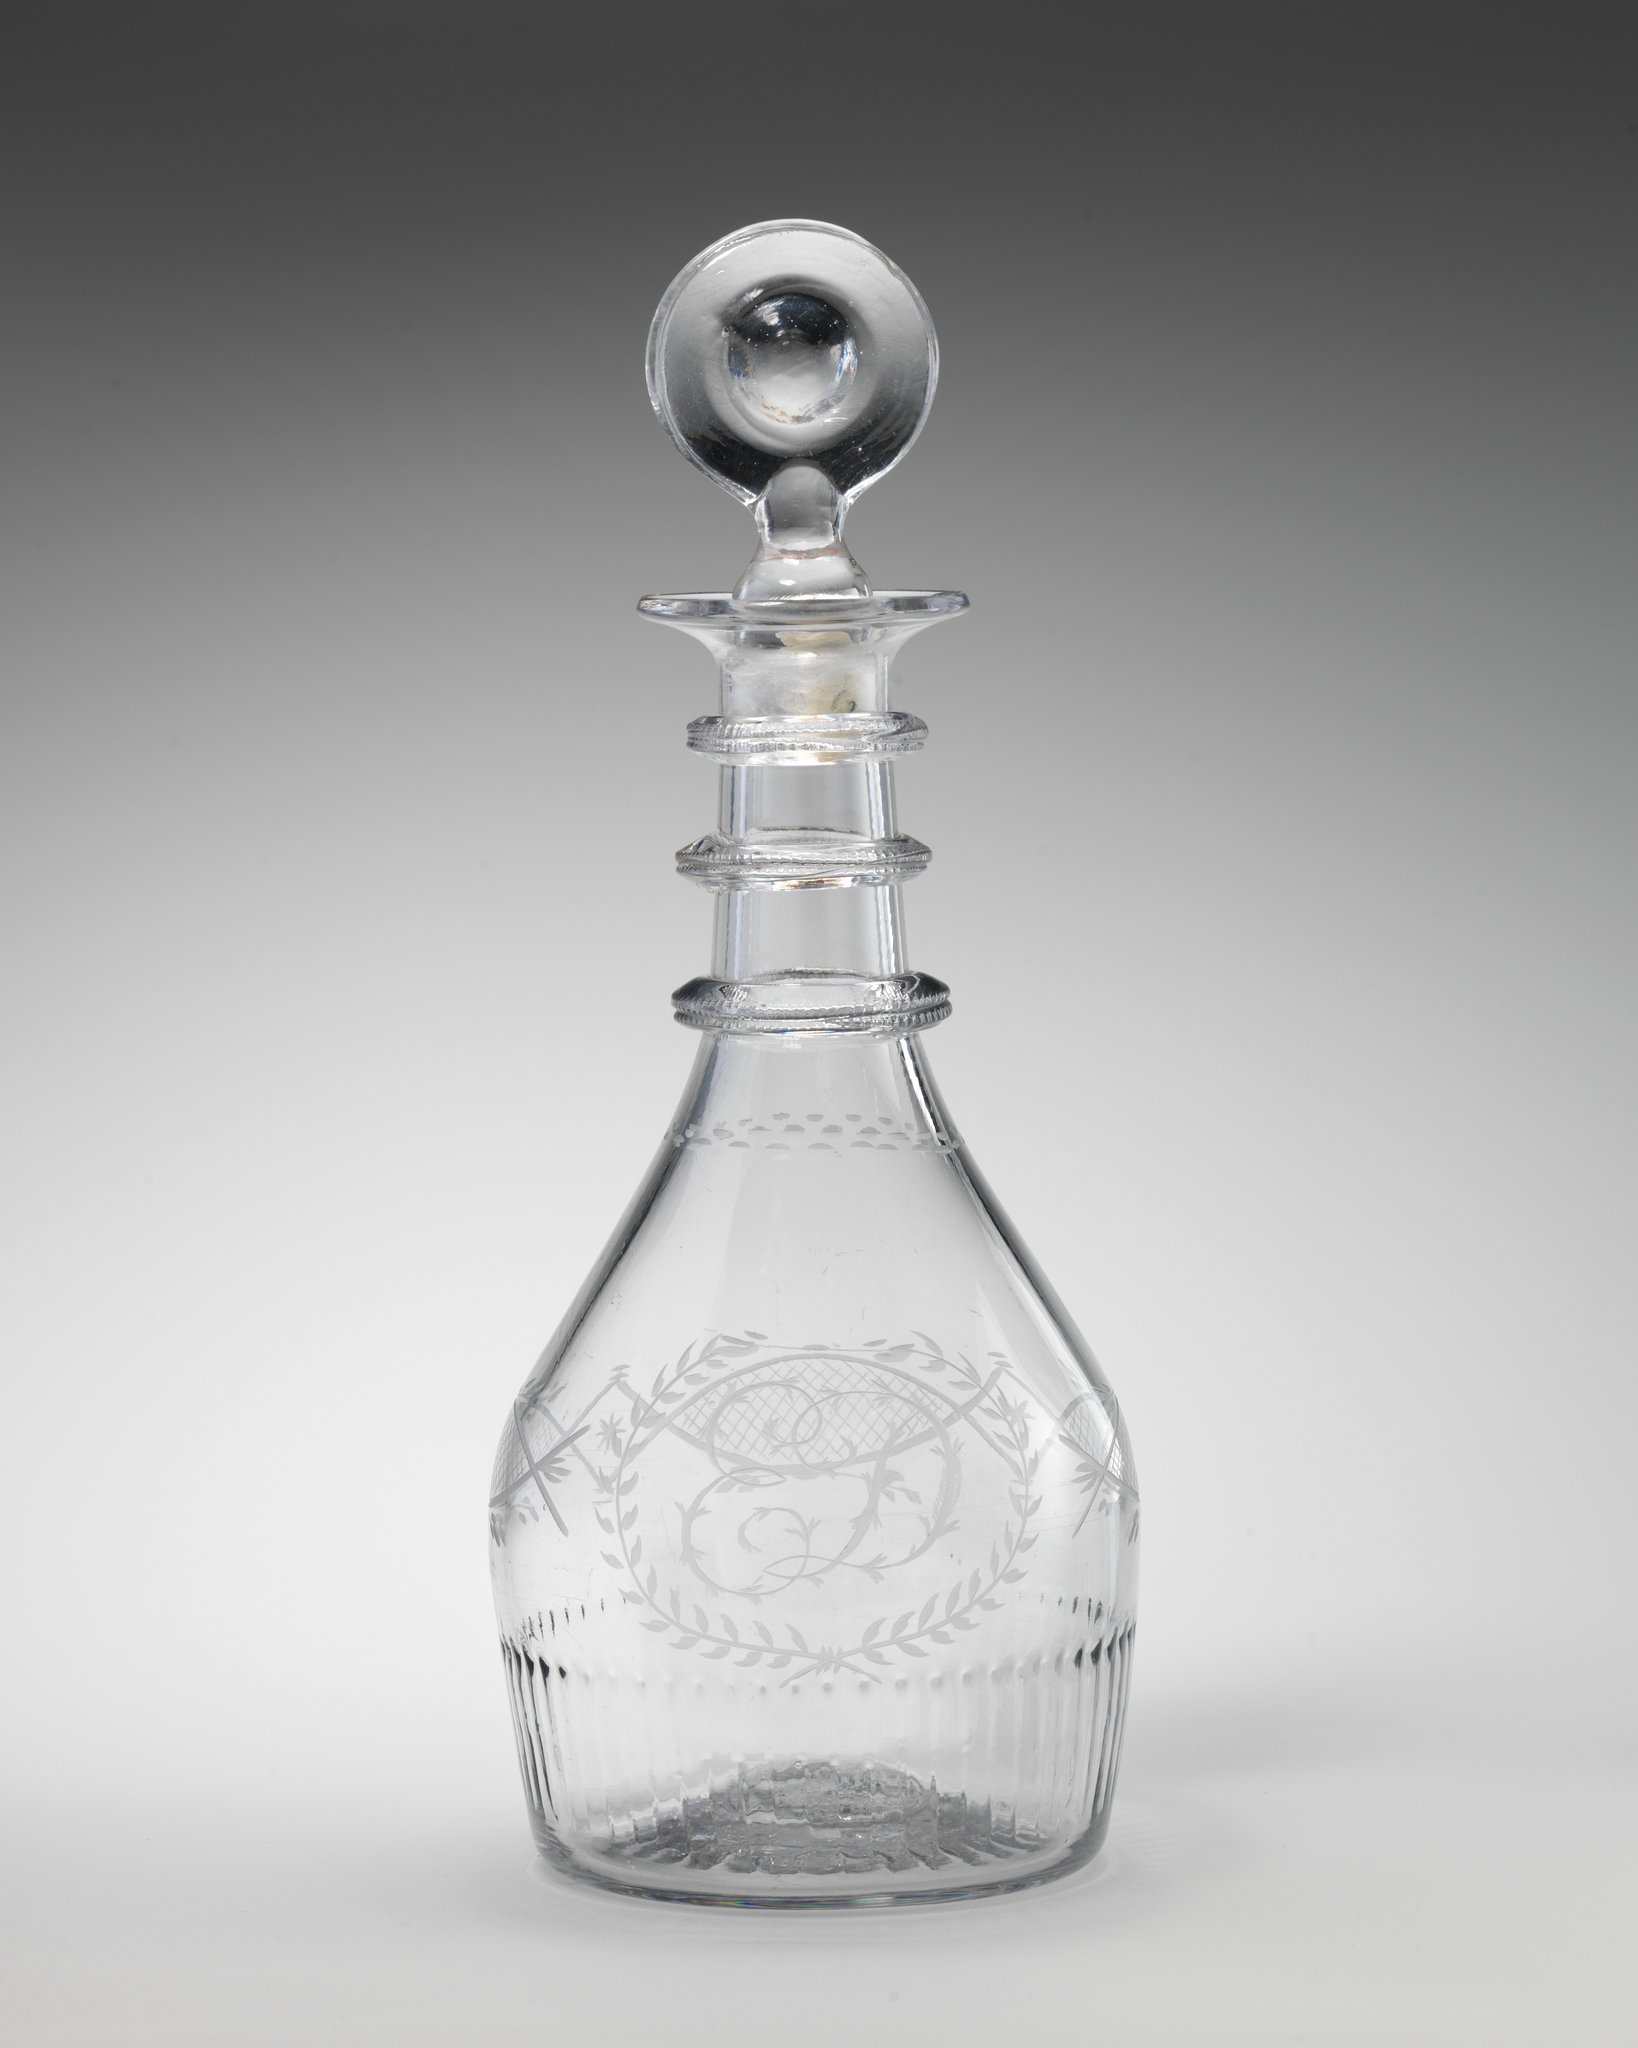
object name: decanter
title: Decanter (one of a pair)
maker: cork glass company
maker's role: maker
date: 1783-1818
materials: glass